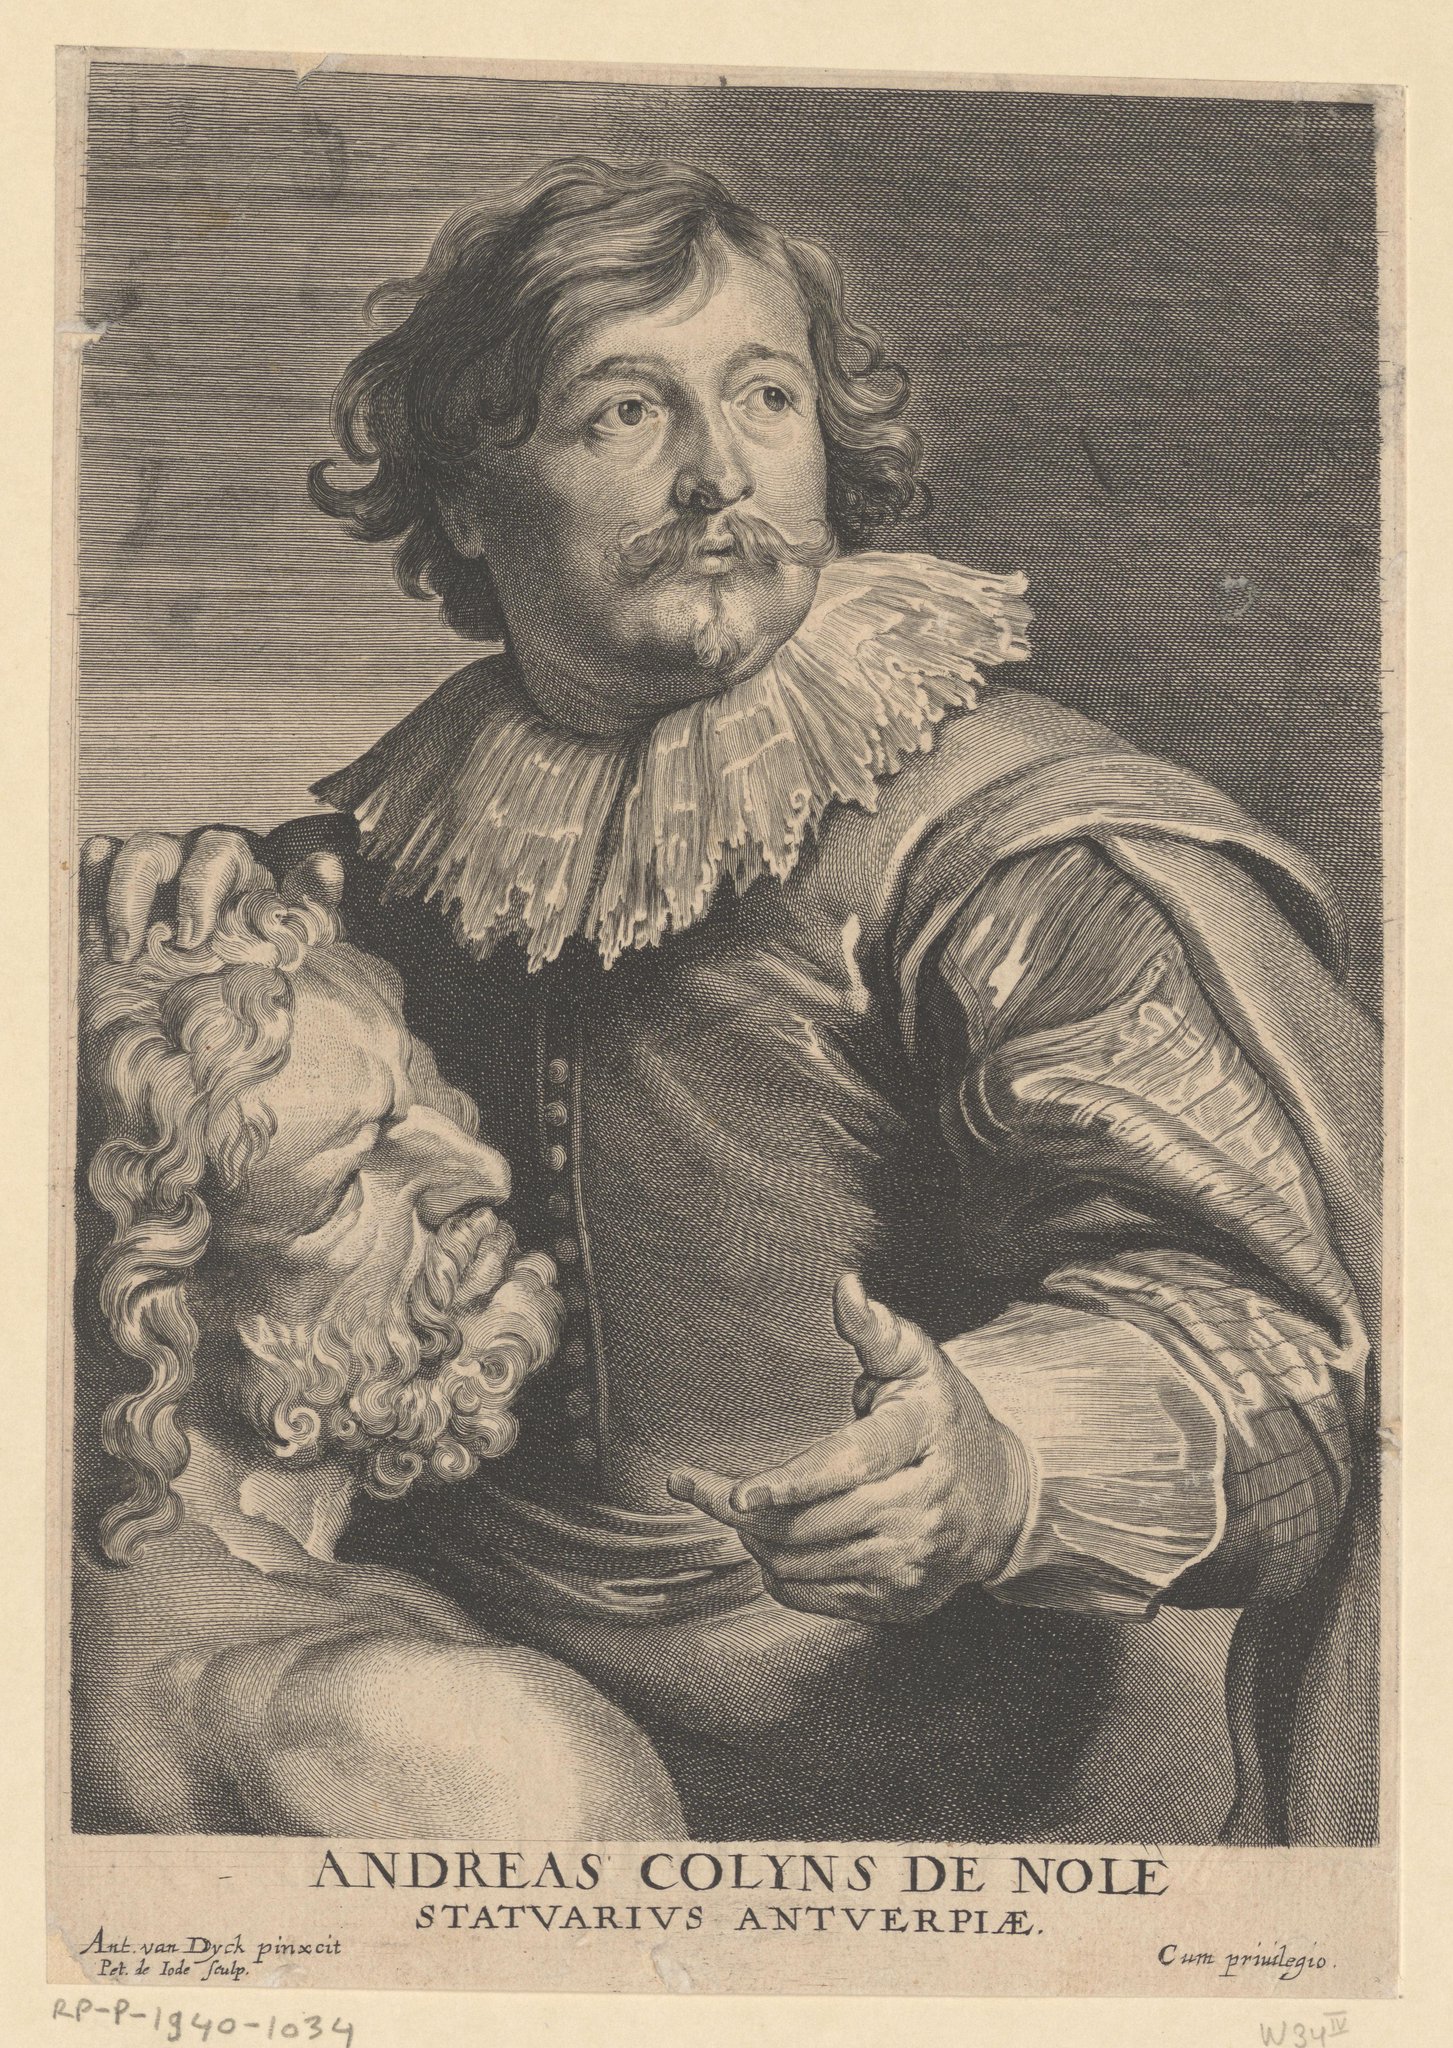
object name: print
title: Portret van Andreas de Nole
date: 1626-1670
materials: paper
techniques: engraving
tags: antwerp, sculptor, andreas de nole, portrait, self-portrait of sculptor, historical persons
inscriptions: collector's mark: 2166, collector's mark: Lugt 2760